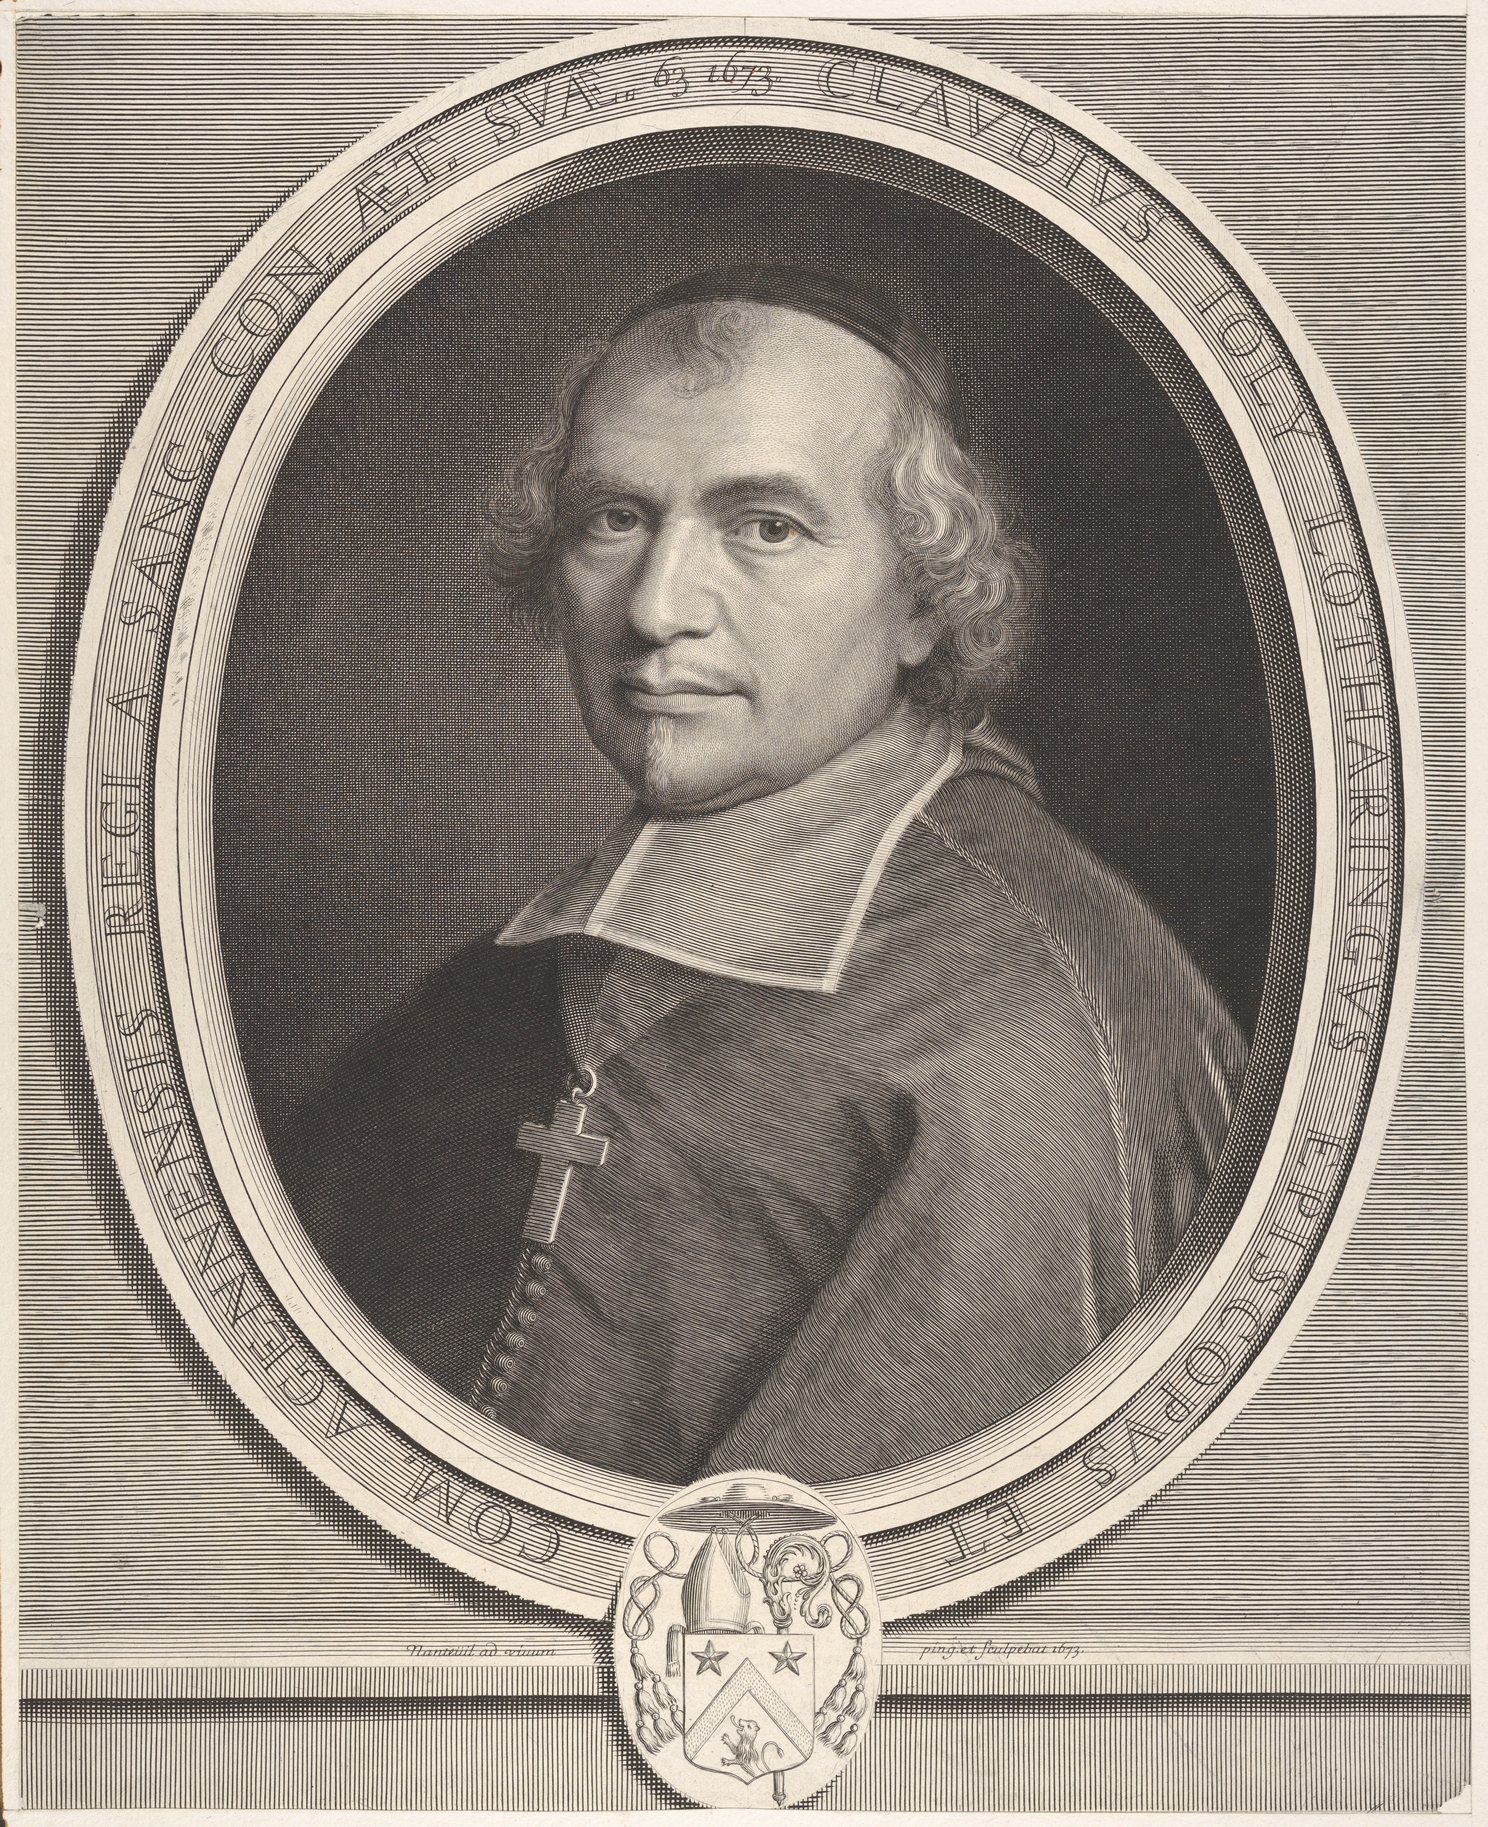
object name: print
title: Claude Joly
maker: robert nanteuil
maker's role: artist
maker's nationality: french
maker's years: 1623-1678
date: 1673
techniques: engraving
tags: men,portraits